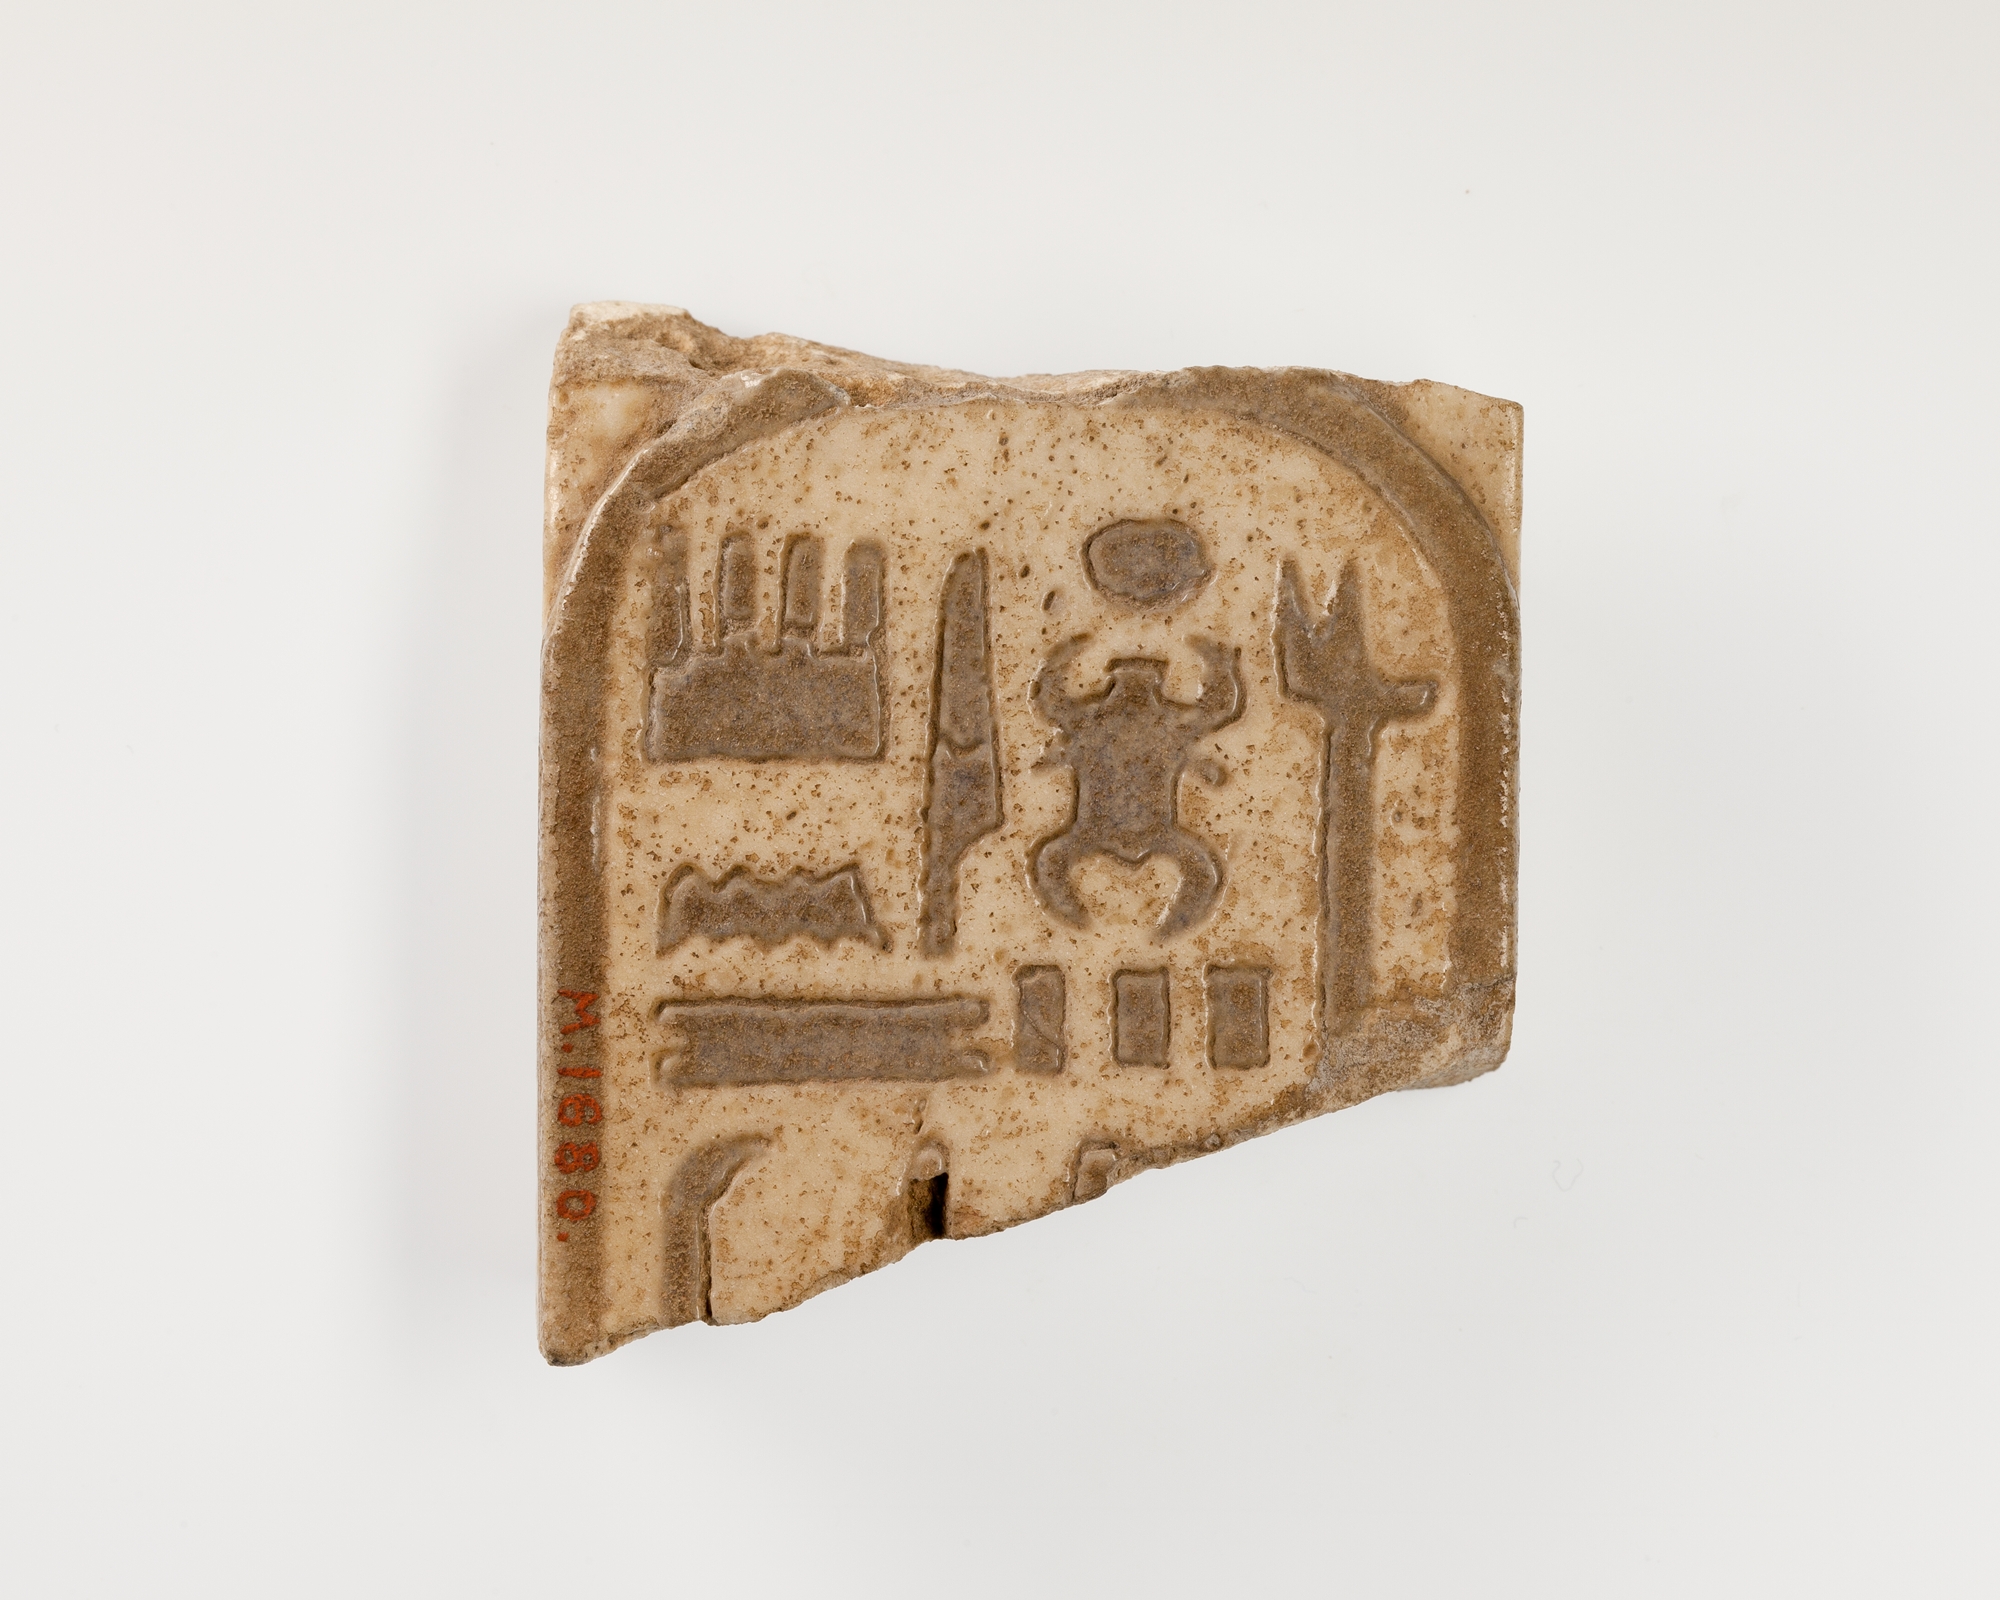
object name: tile fragment, seti ii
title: Fragment of tile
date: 1295-1070 BCE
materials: limestone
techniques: glazing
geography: egypt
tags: hieroglyphs